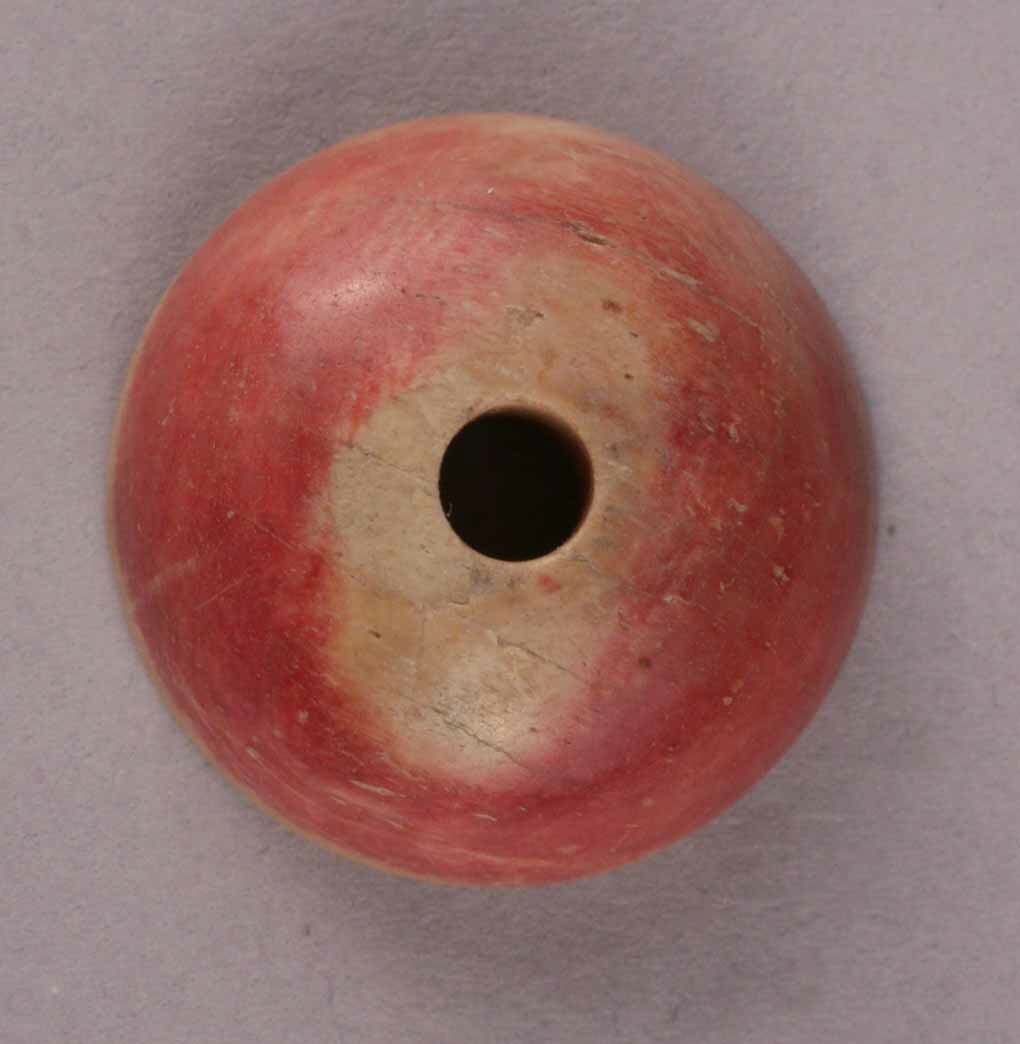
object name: spindle whorl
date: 801-1000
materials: bone, paint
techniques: incising, inlay, tinting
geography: iran